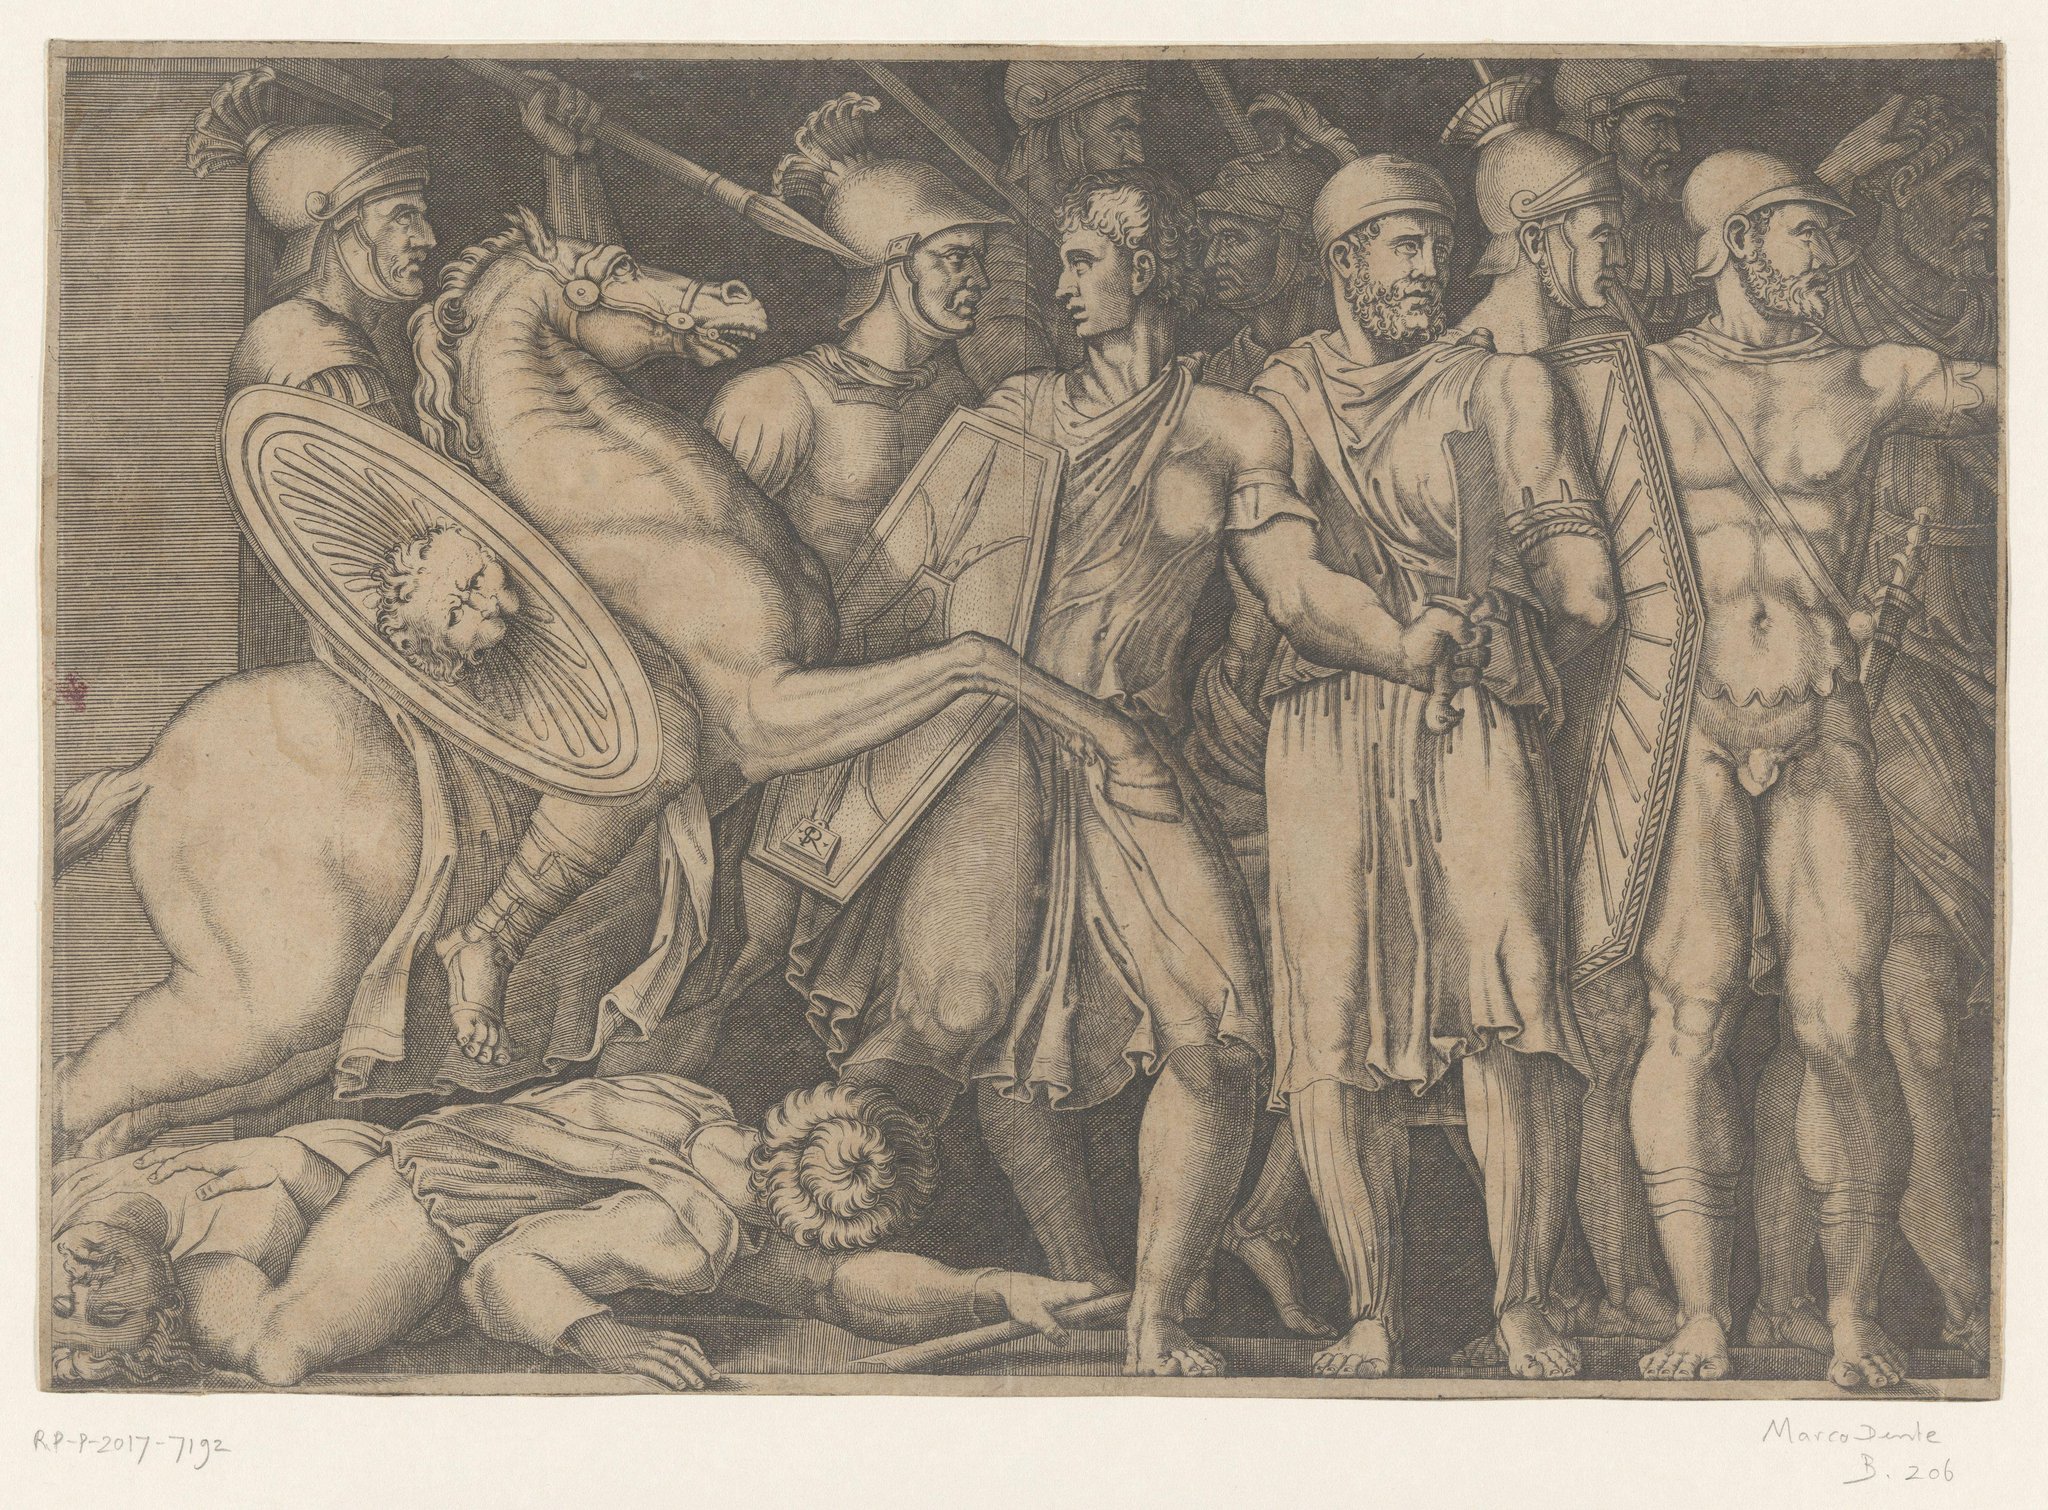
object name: print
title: Trajanus vechtend met Daciërs, ca. 101-106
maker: marco dente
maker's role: print maker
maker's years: 1486-1527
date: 1498-1532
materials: paper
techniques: engraving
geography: italy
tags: (story of) the emperor trajan - aggressive relationships of person from classical history, (story of) the emperor trajan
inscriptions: collector's mark: ‘AP 177’, collector's mark: Lugt 2228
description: Keizer Trajanus te paard in gevecht met de Daciërs. Twee Daciërs liggen onder zijn steigerende paard. Rechts twee gevangen Daciërs met daarachter Romeinse soldaten. UIt de Dacische oorlogen, 101-106.